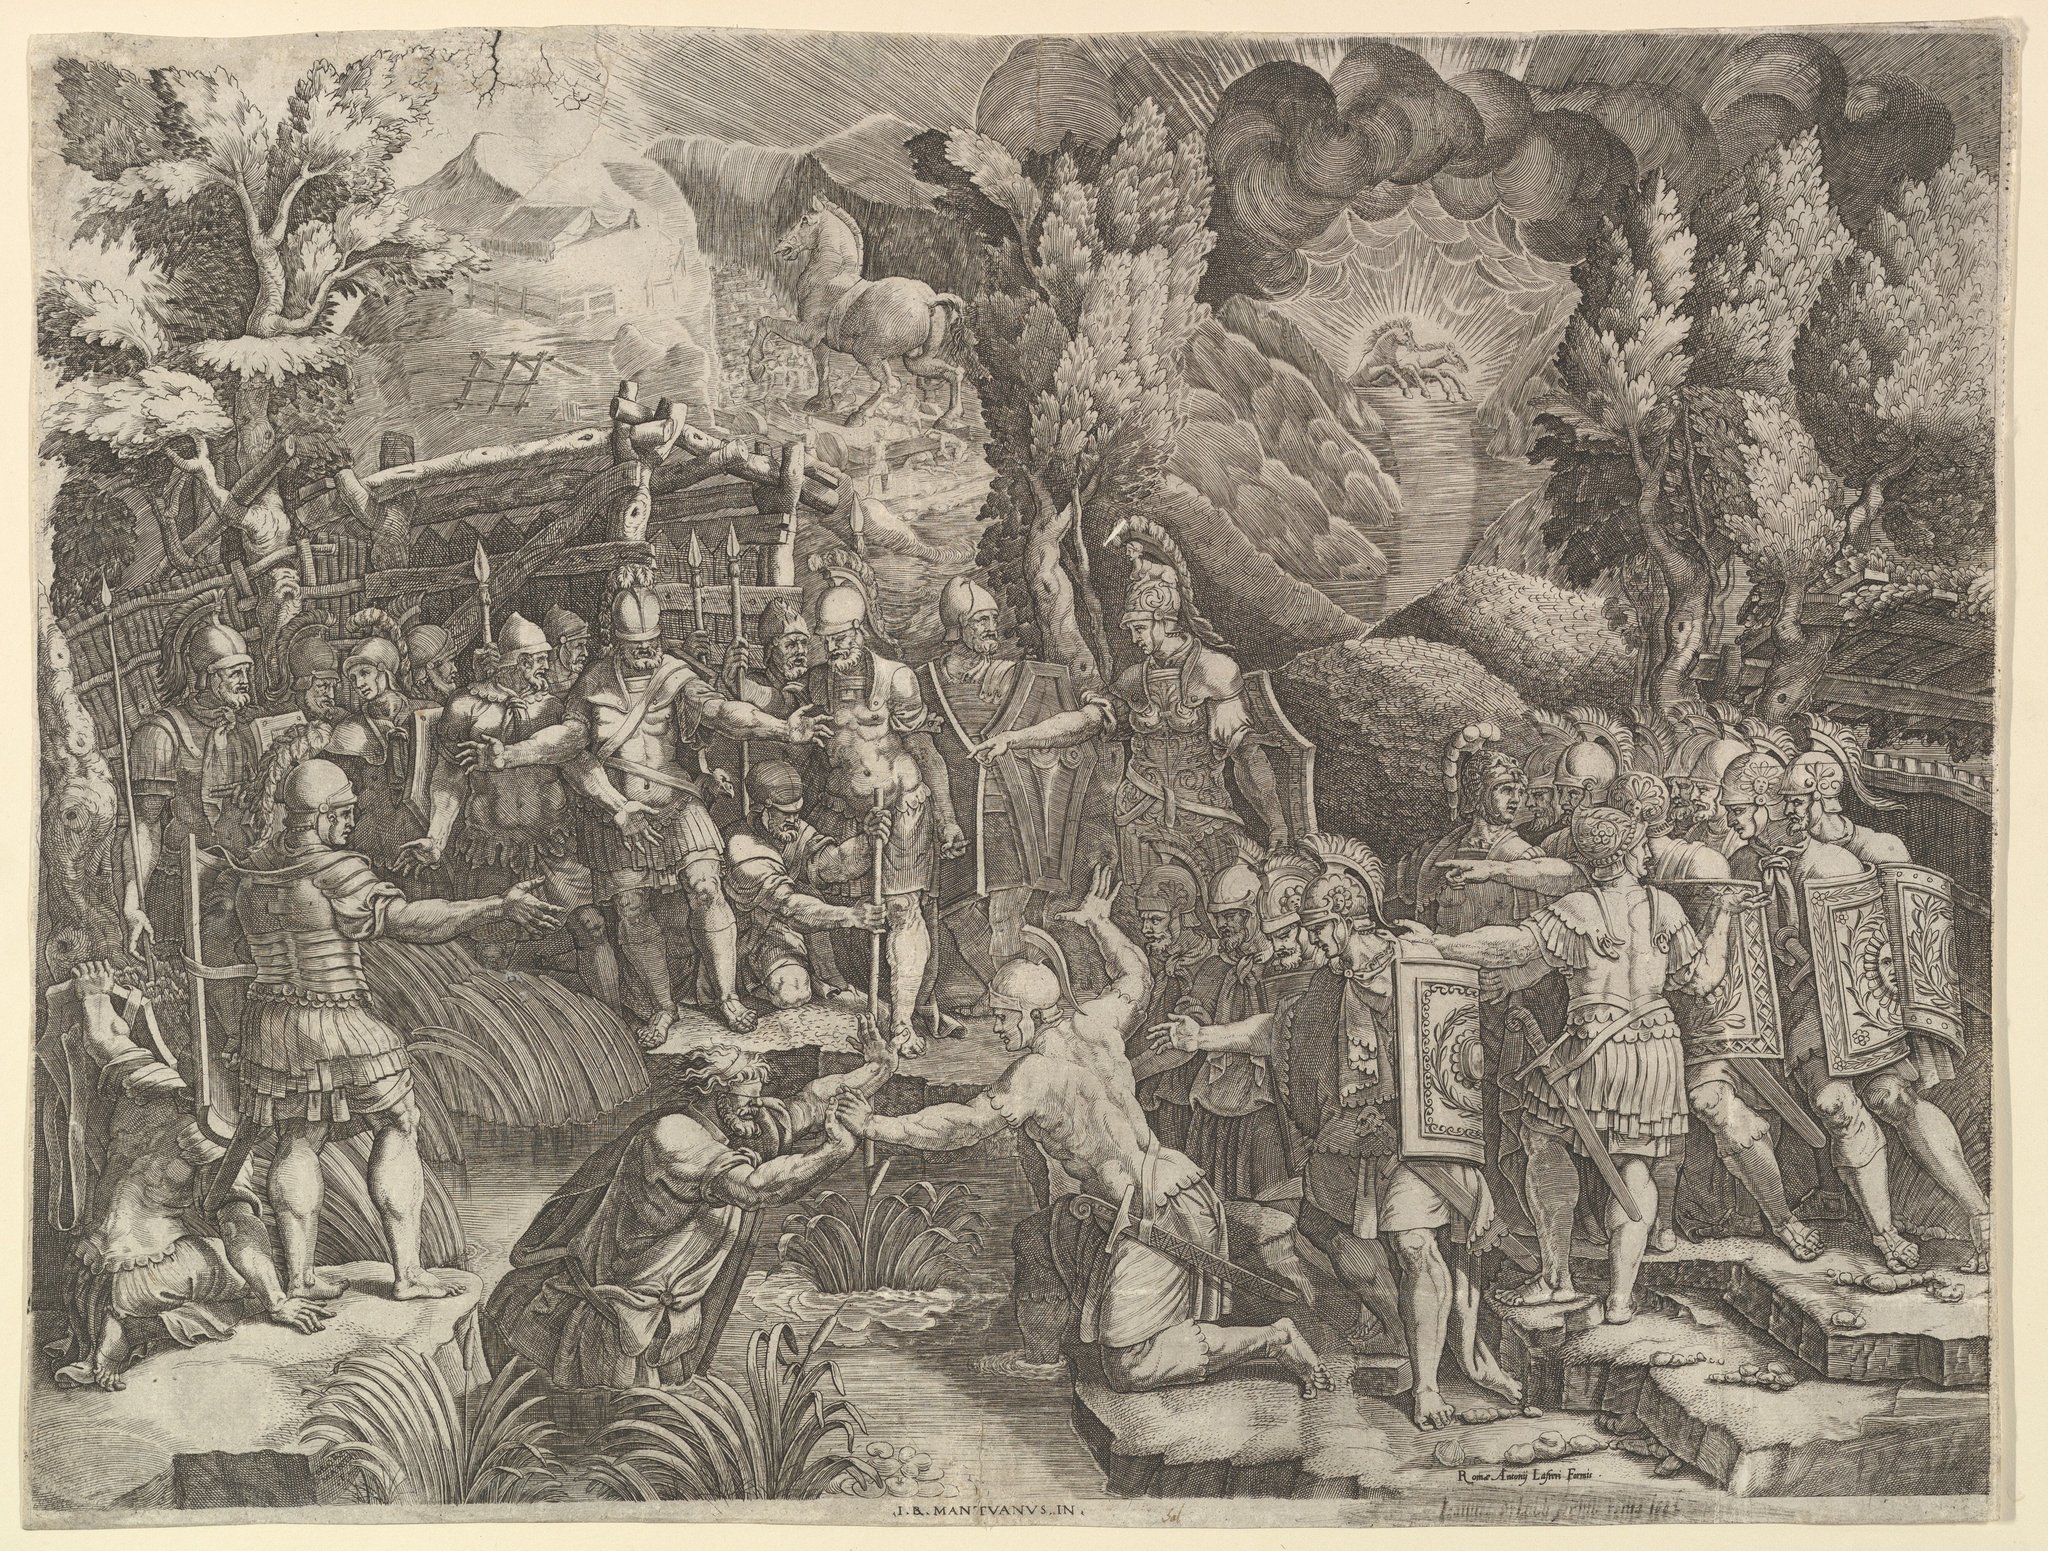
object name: print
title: Sinon Deceiving the Trojans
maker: giorgio ghisi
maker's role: artist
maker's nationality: italian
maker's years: 1515-1582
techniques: engraving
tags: soldiers,trojan war